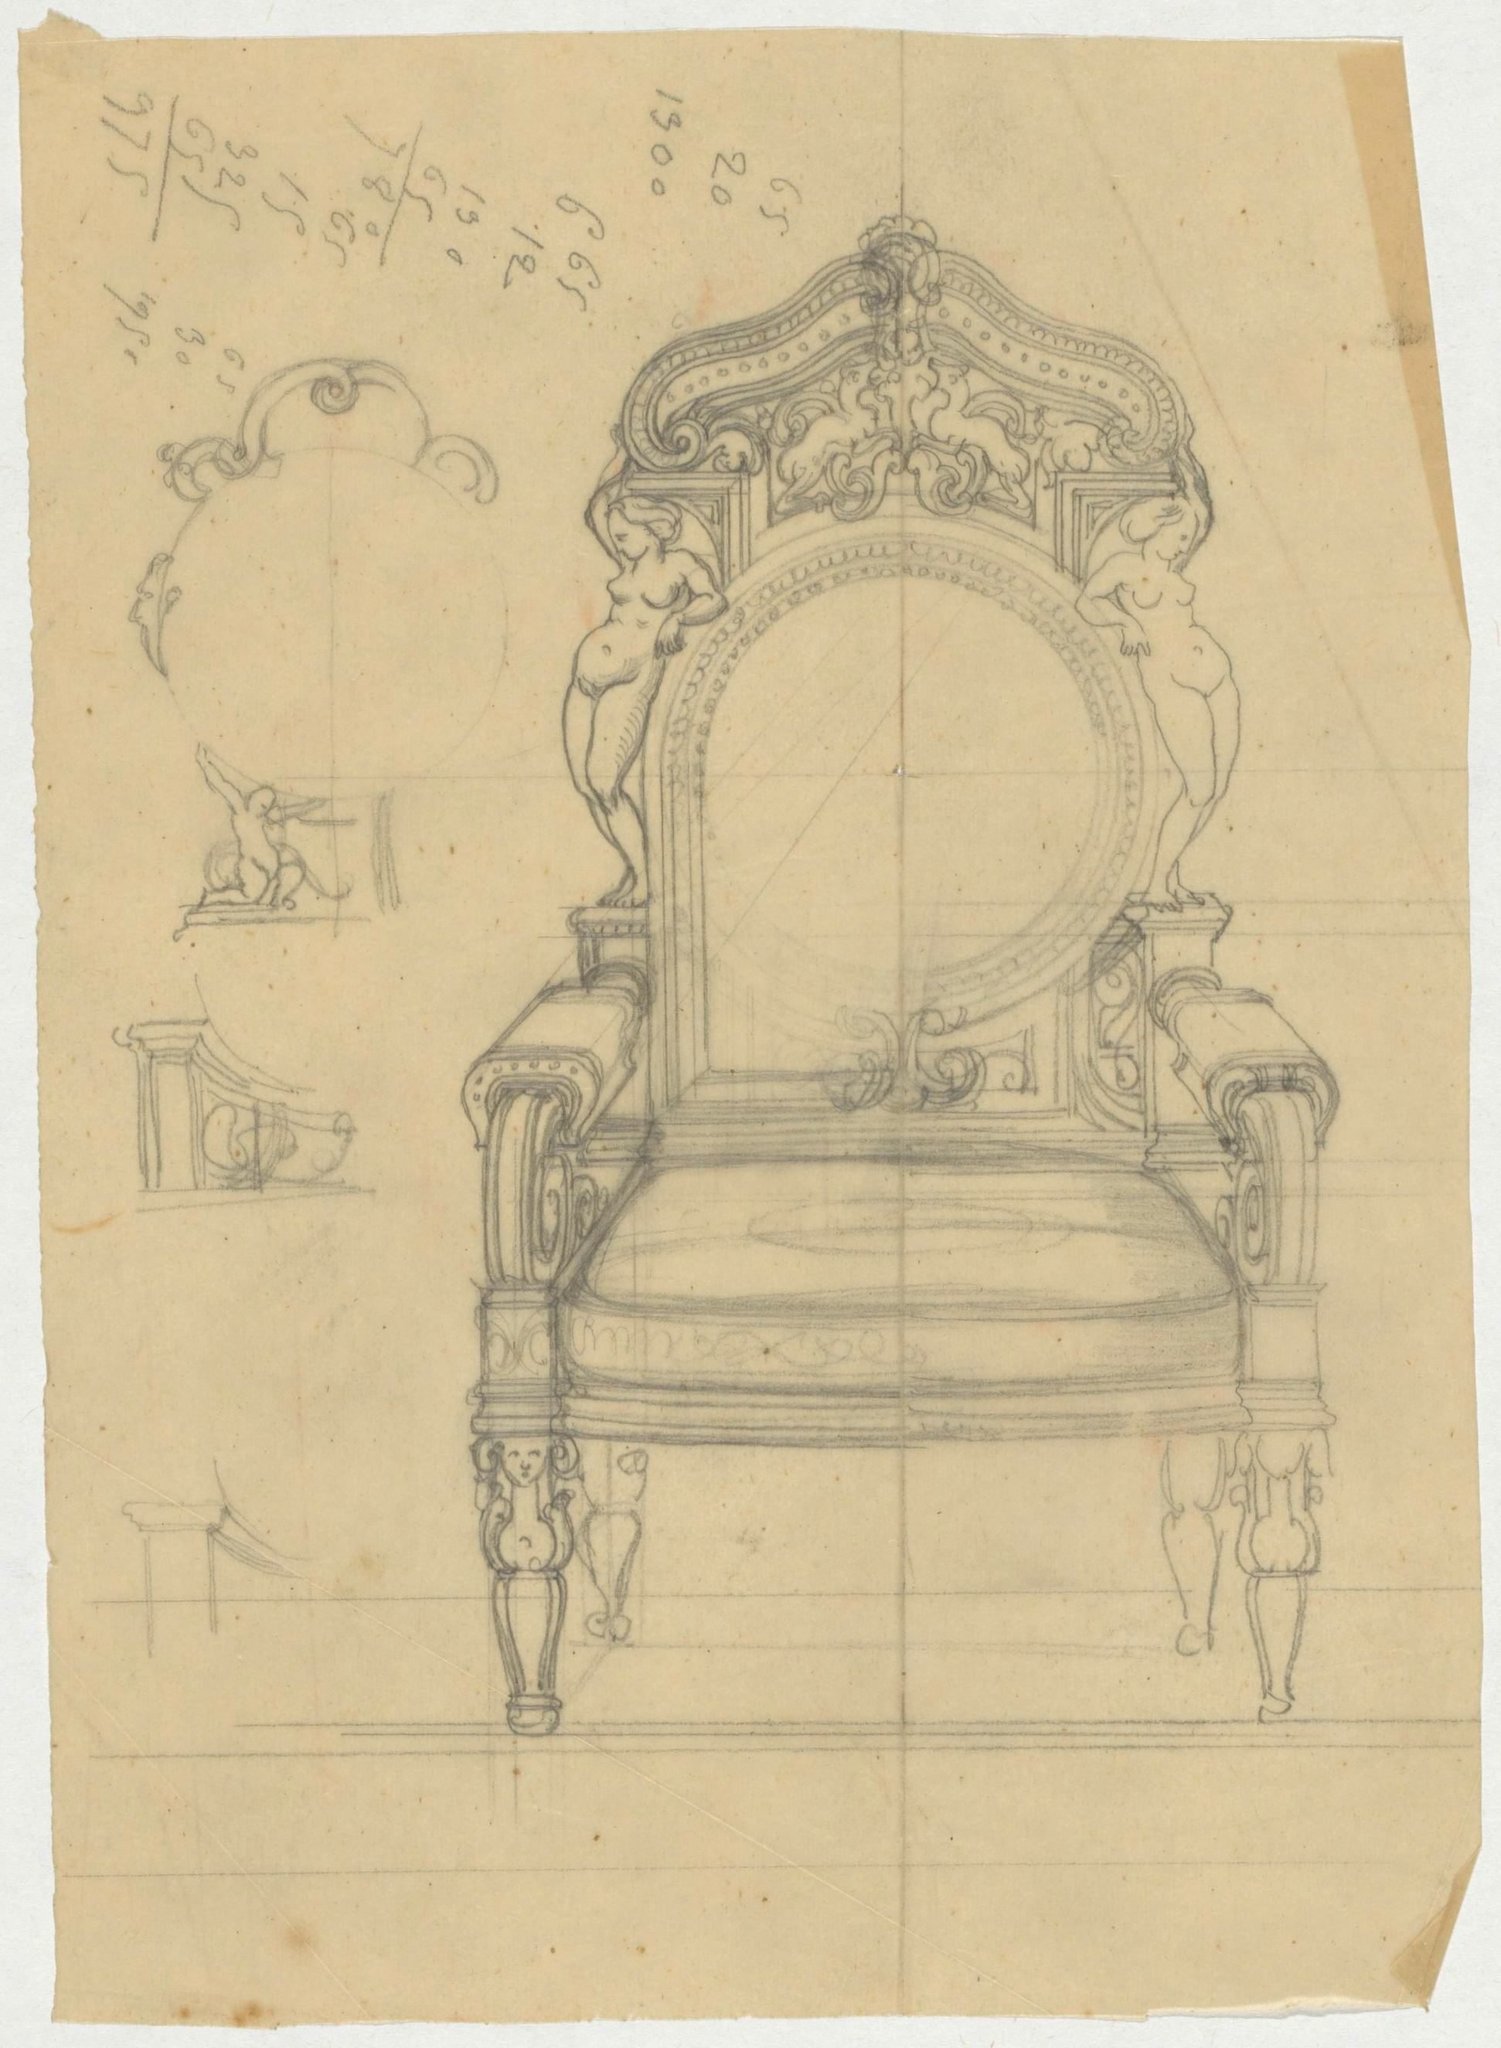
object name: design drawing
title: Armstoel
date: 1830-1850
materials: graphite, paper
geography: paris